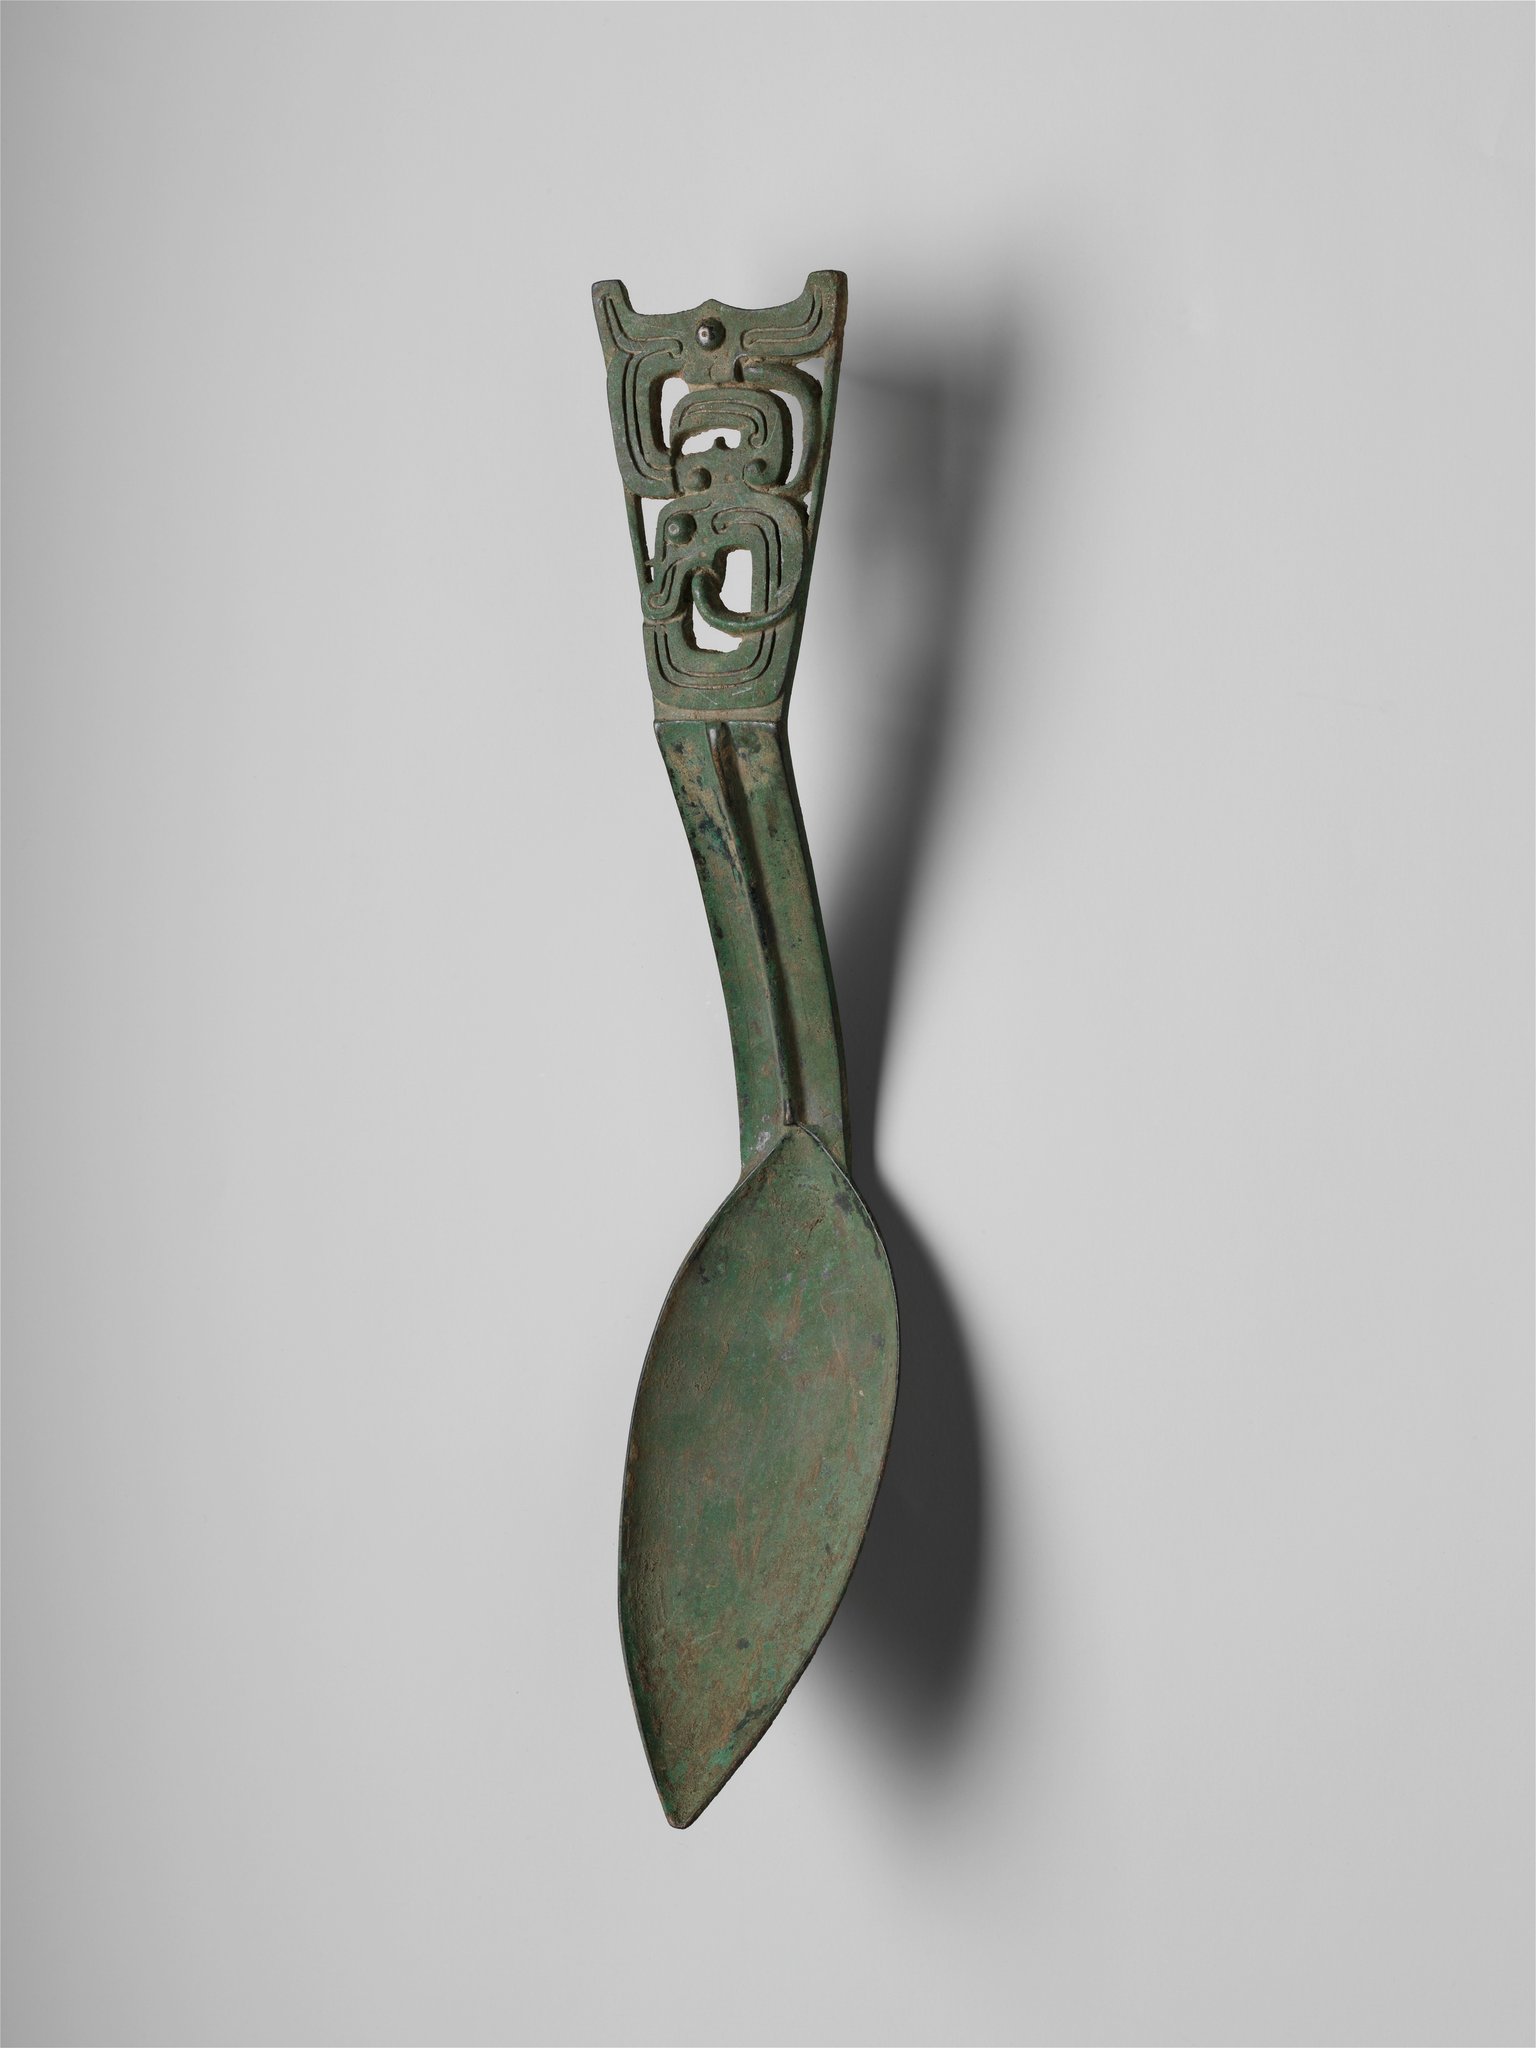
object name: spoon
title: Spoon (Bi)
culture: chinese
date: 834-768 BCE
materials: bronze